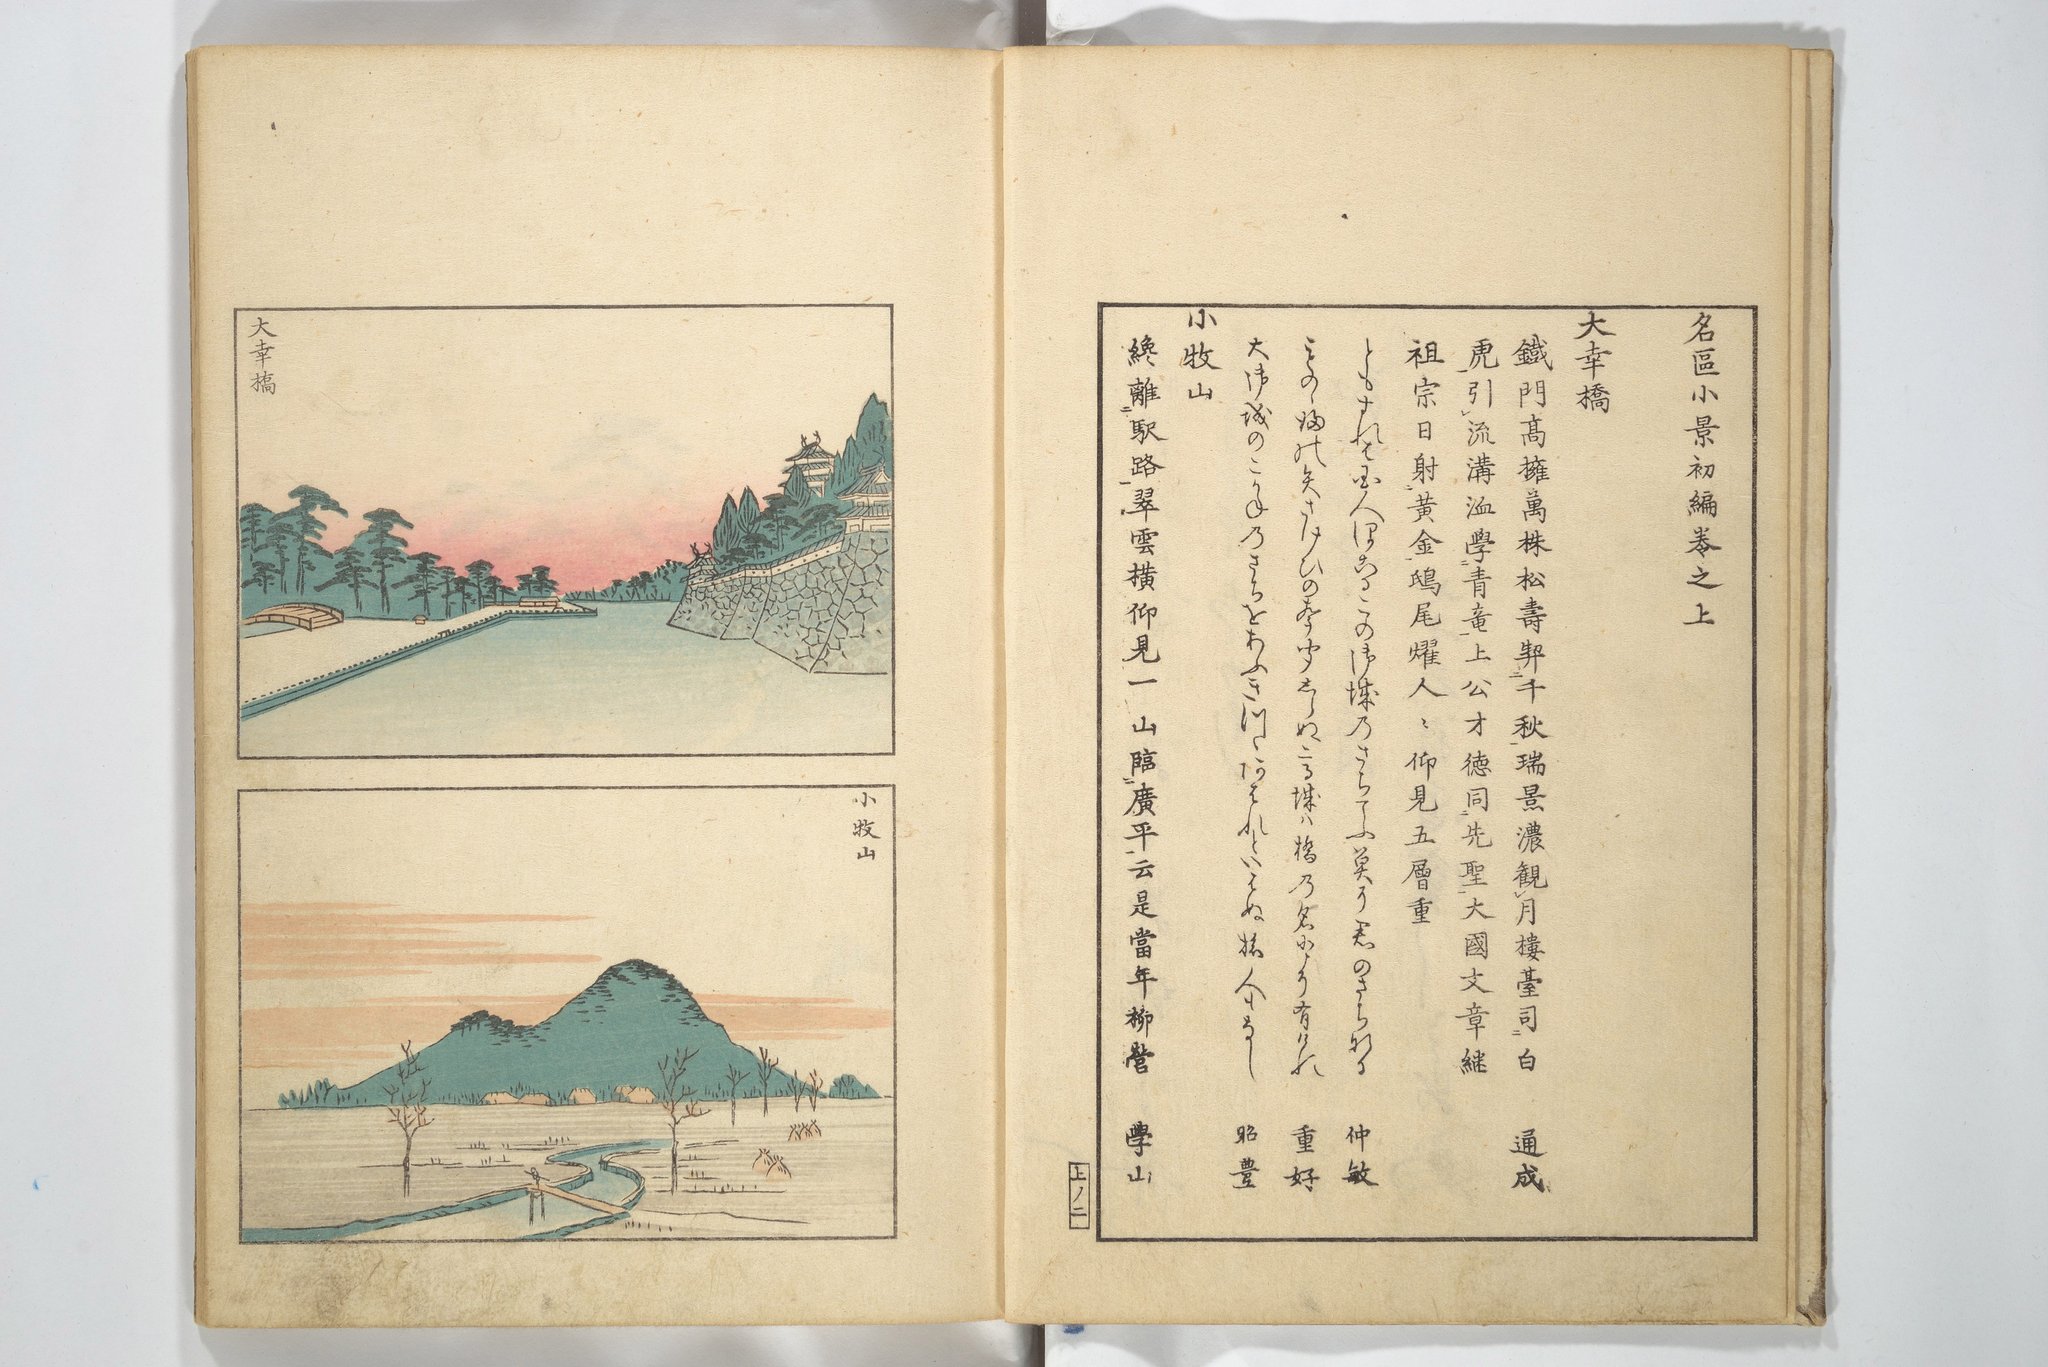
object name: illustrated book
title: Famous Places in Owari (Meiku shōkei shohen ) 名区小景 初編之下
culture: japanese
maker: katsukawa shunkō 勝川春好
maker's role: artist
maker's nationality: japanese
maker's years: 1743-1812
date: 1847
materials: ink, paper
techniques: woodblock print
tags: landscapes